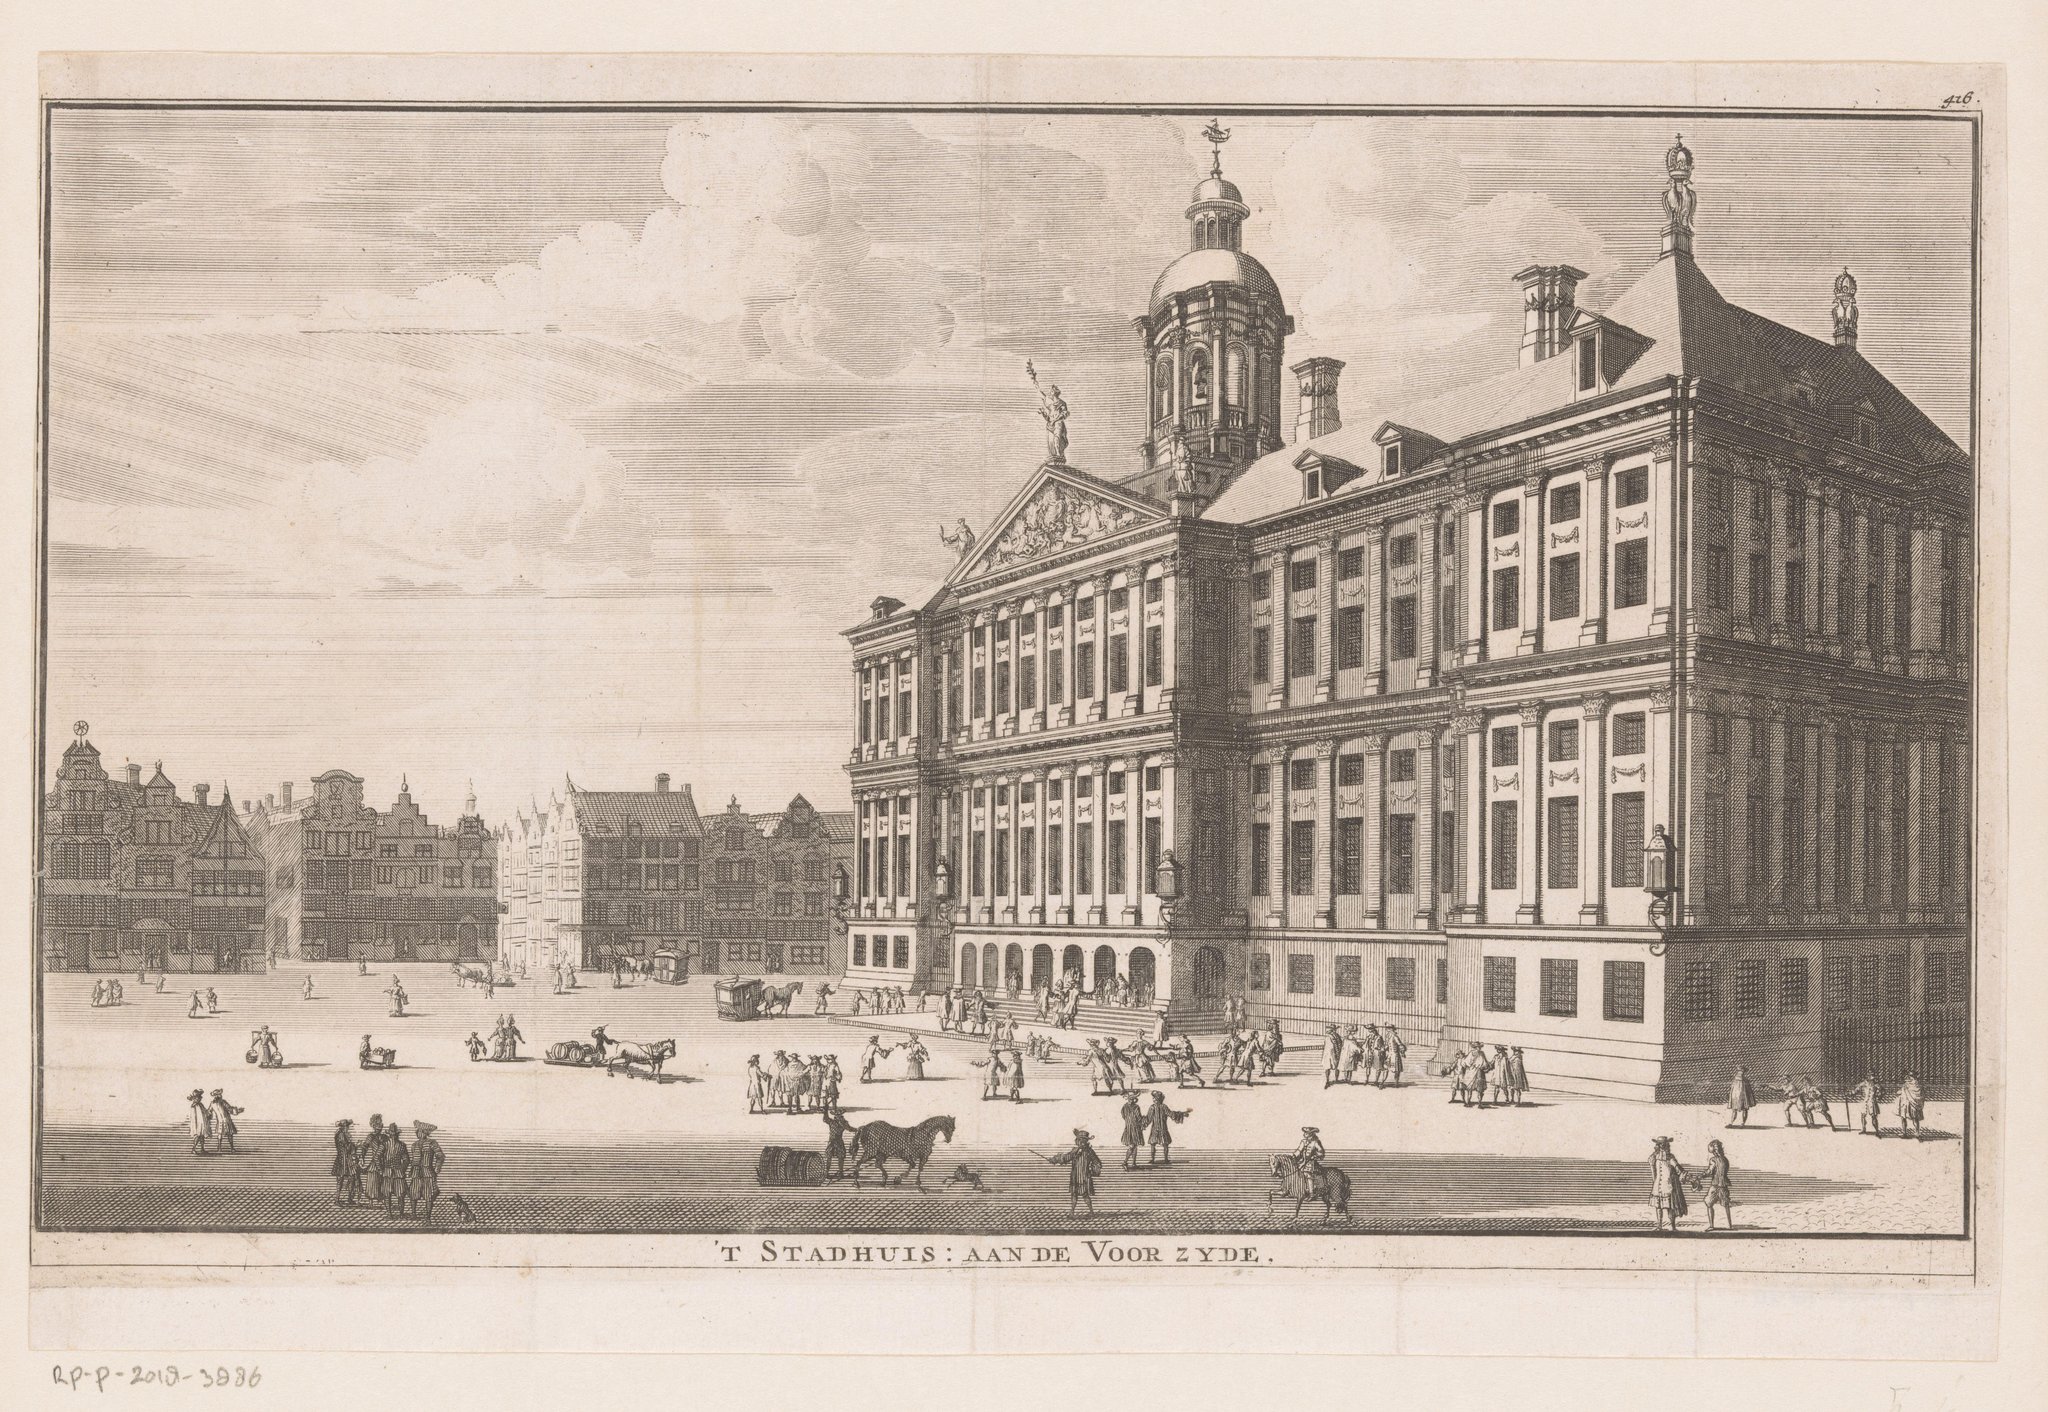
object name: print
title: Gezicht op het Koninklijk Paleis te Amsterdam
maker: albert de putter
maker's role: print maker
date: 1700-1725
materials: paper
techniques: etching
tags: palace, royal palace of amsterdam